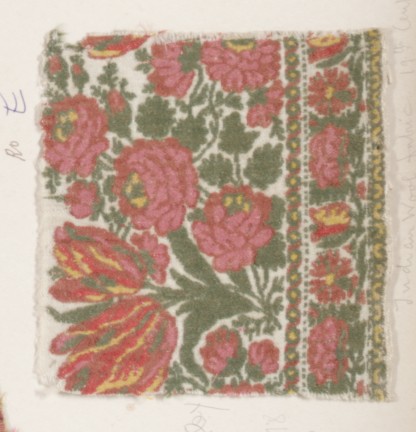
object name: fragment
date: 1801-1900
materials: wool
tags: flowers,leaves